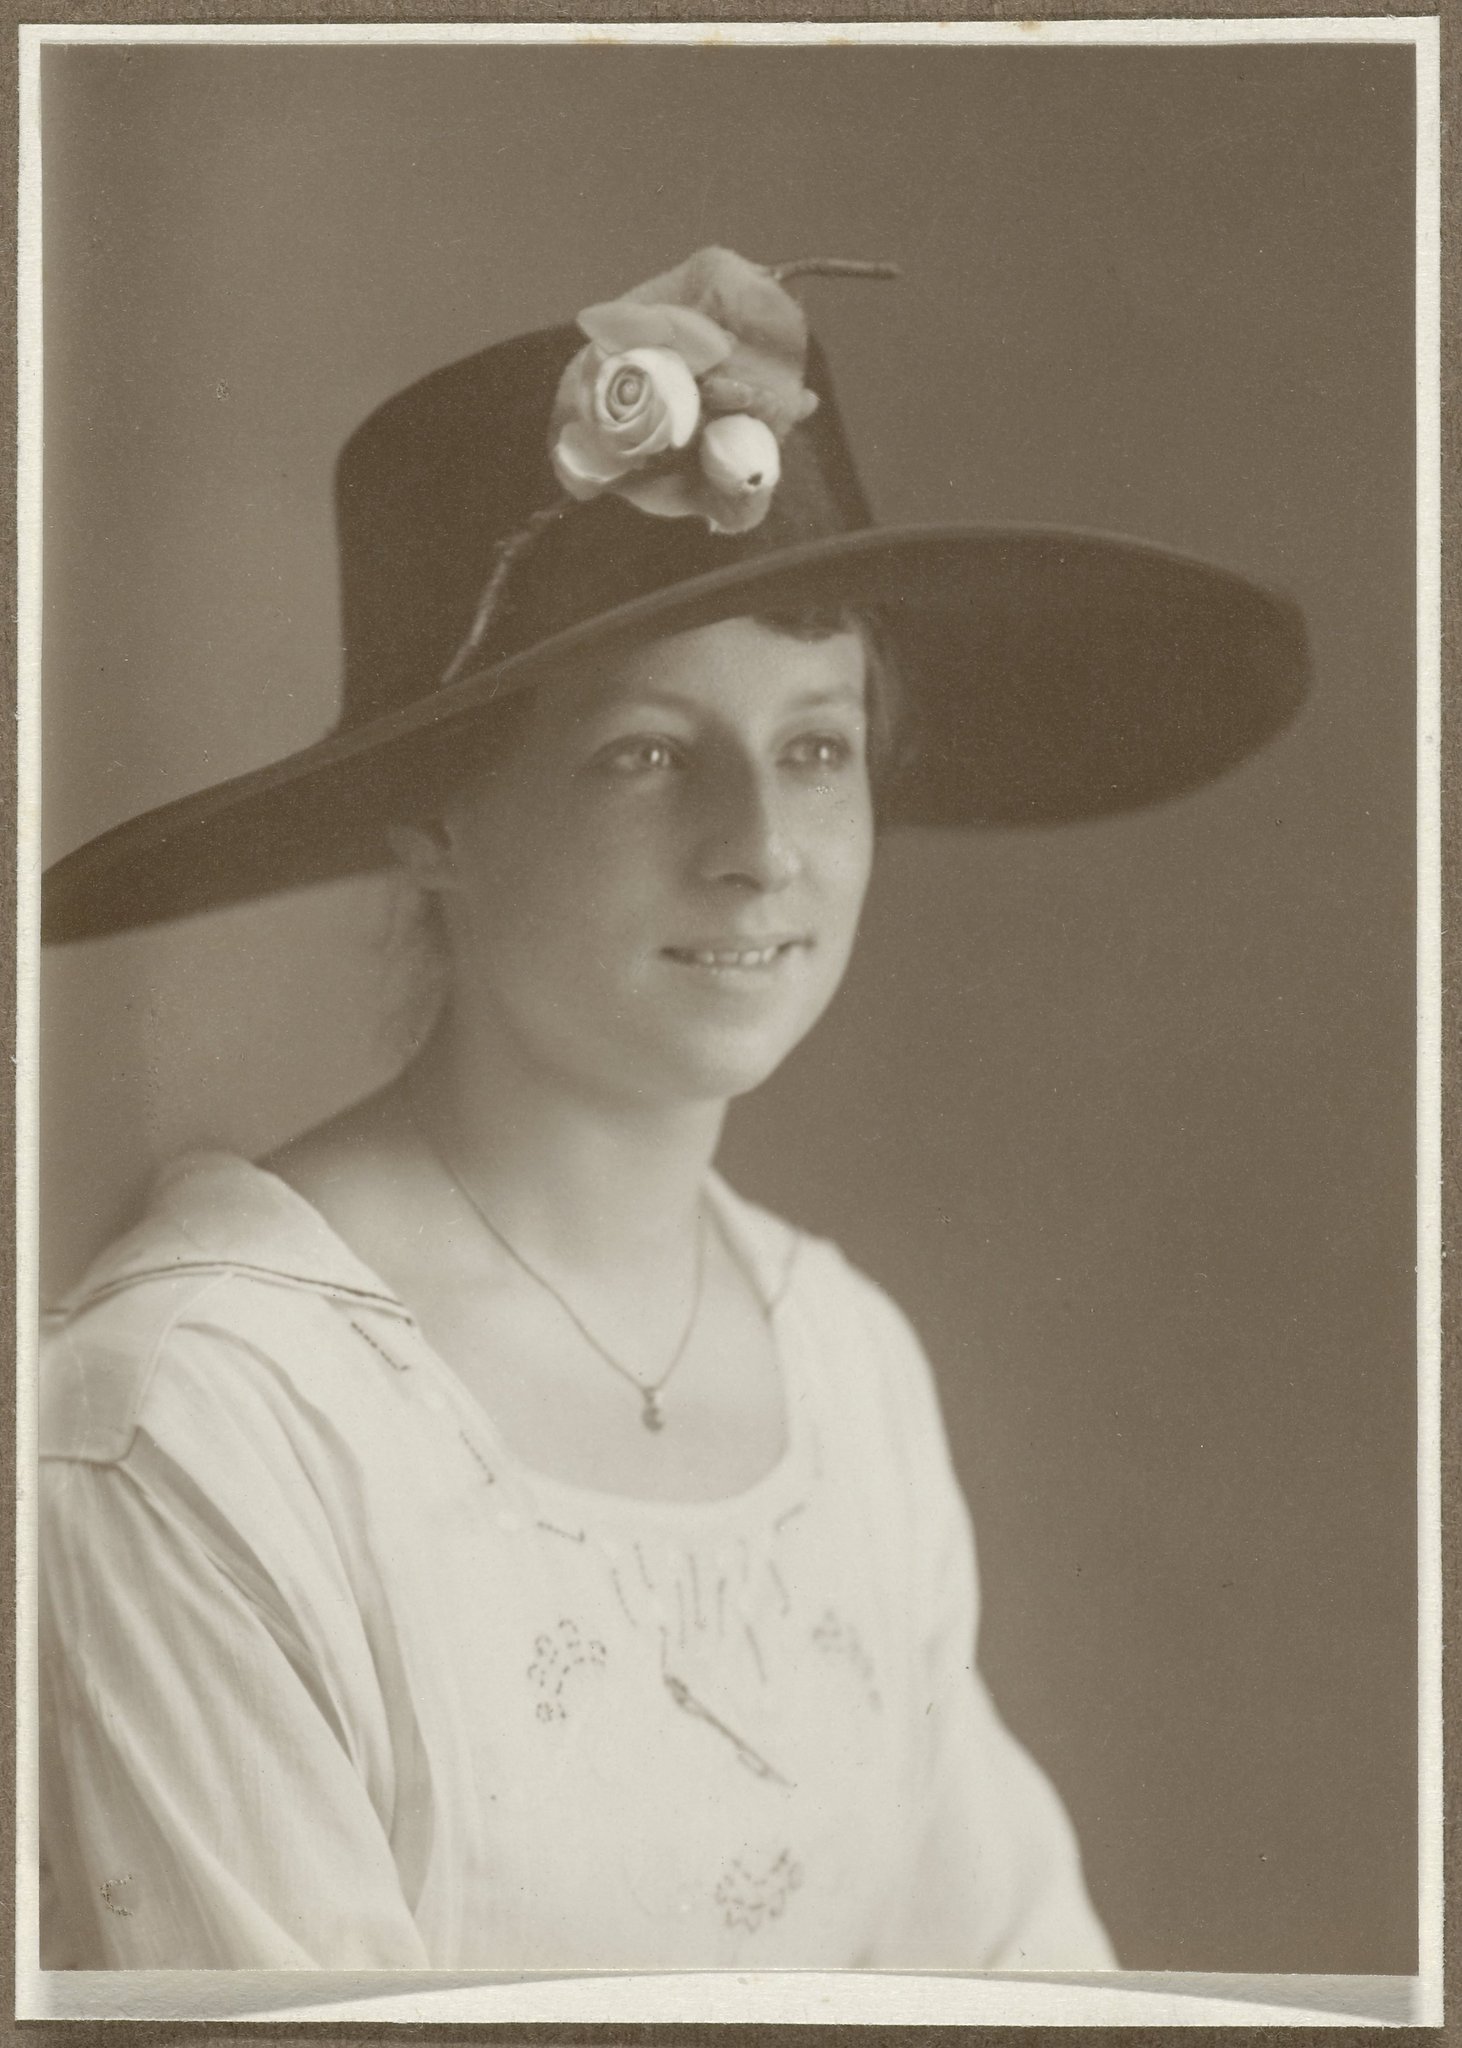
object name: photograph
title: Portret van een onbekende jonge vrouw met hoed, Soerabaja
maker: onnes kurkdjian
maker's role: fotograaf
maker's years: 1851-1903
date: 1890-1920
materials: paper, cardboard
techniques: gelatin silver print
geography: surabaya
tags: adolescent, young woman, maiden, anonymous historical person portrayed, surabaya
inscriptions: check stamp: ‘photo/ Kurkdjian/ Soerabaia’